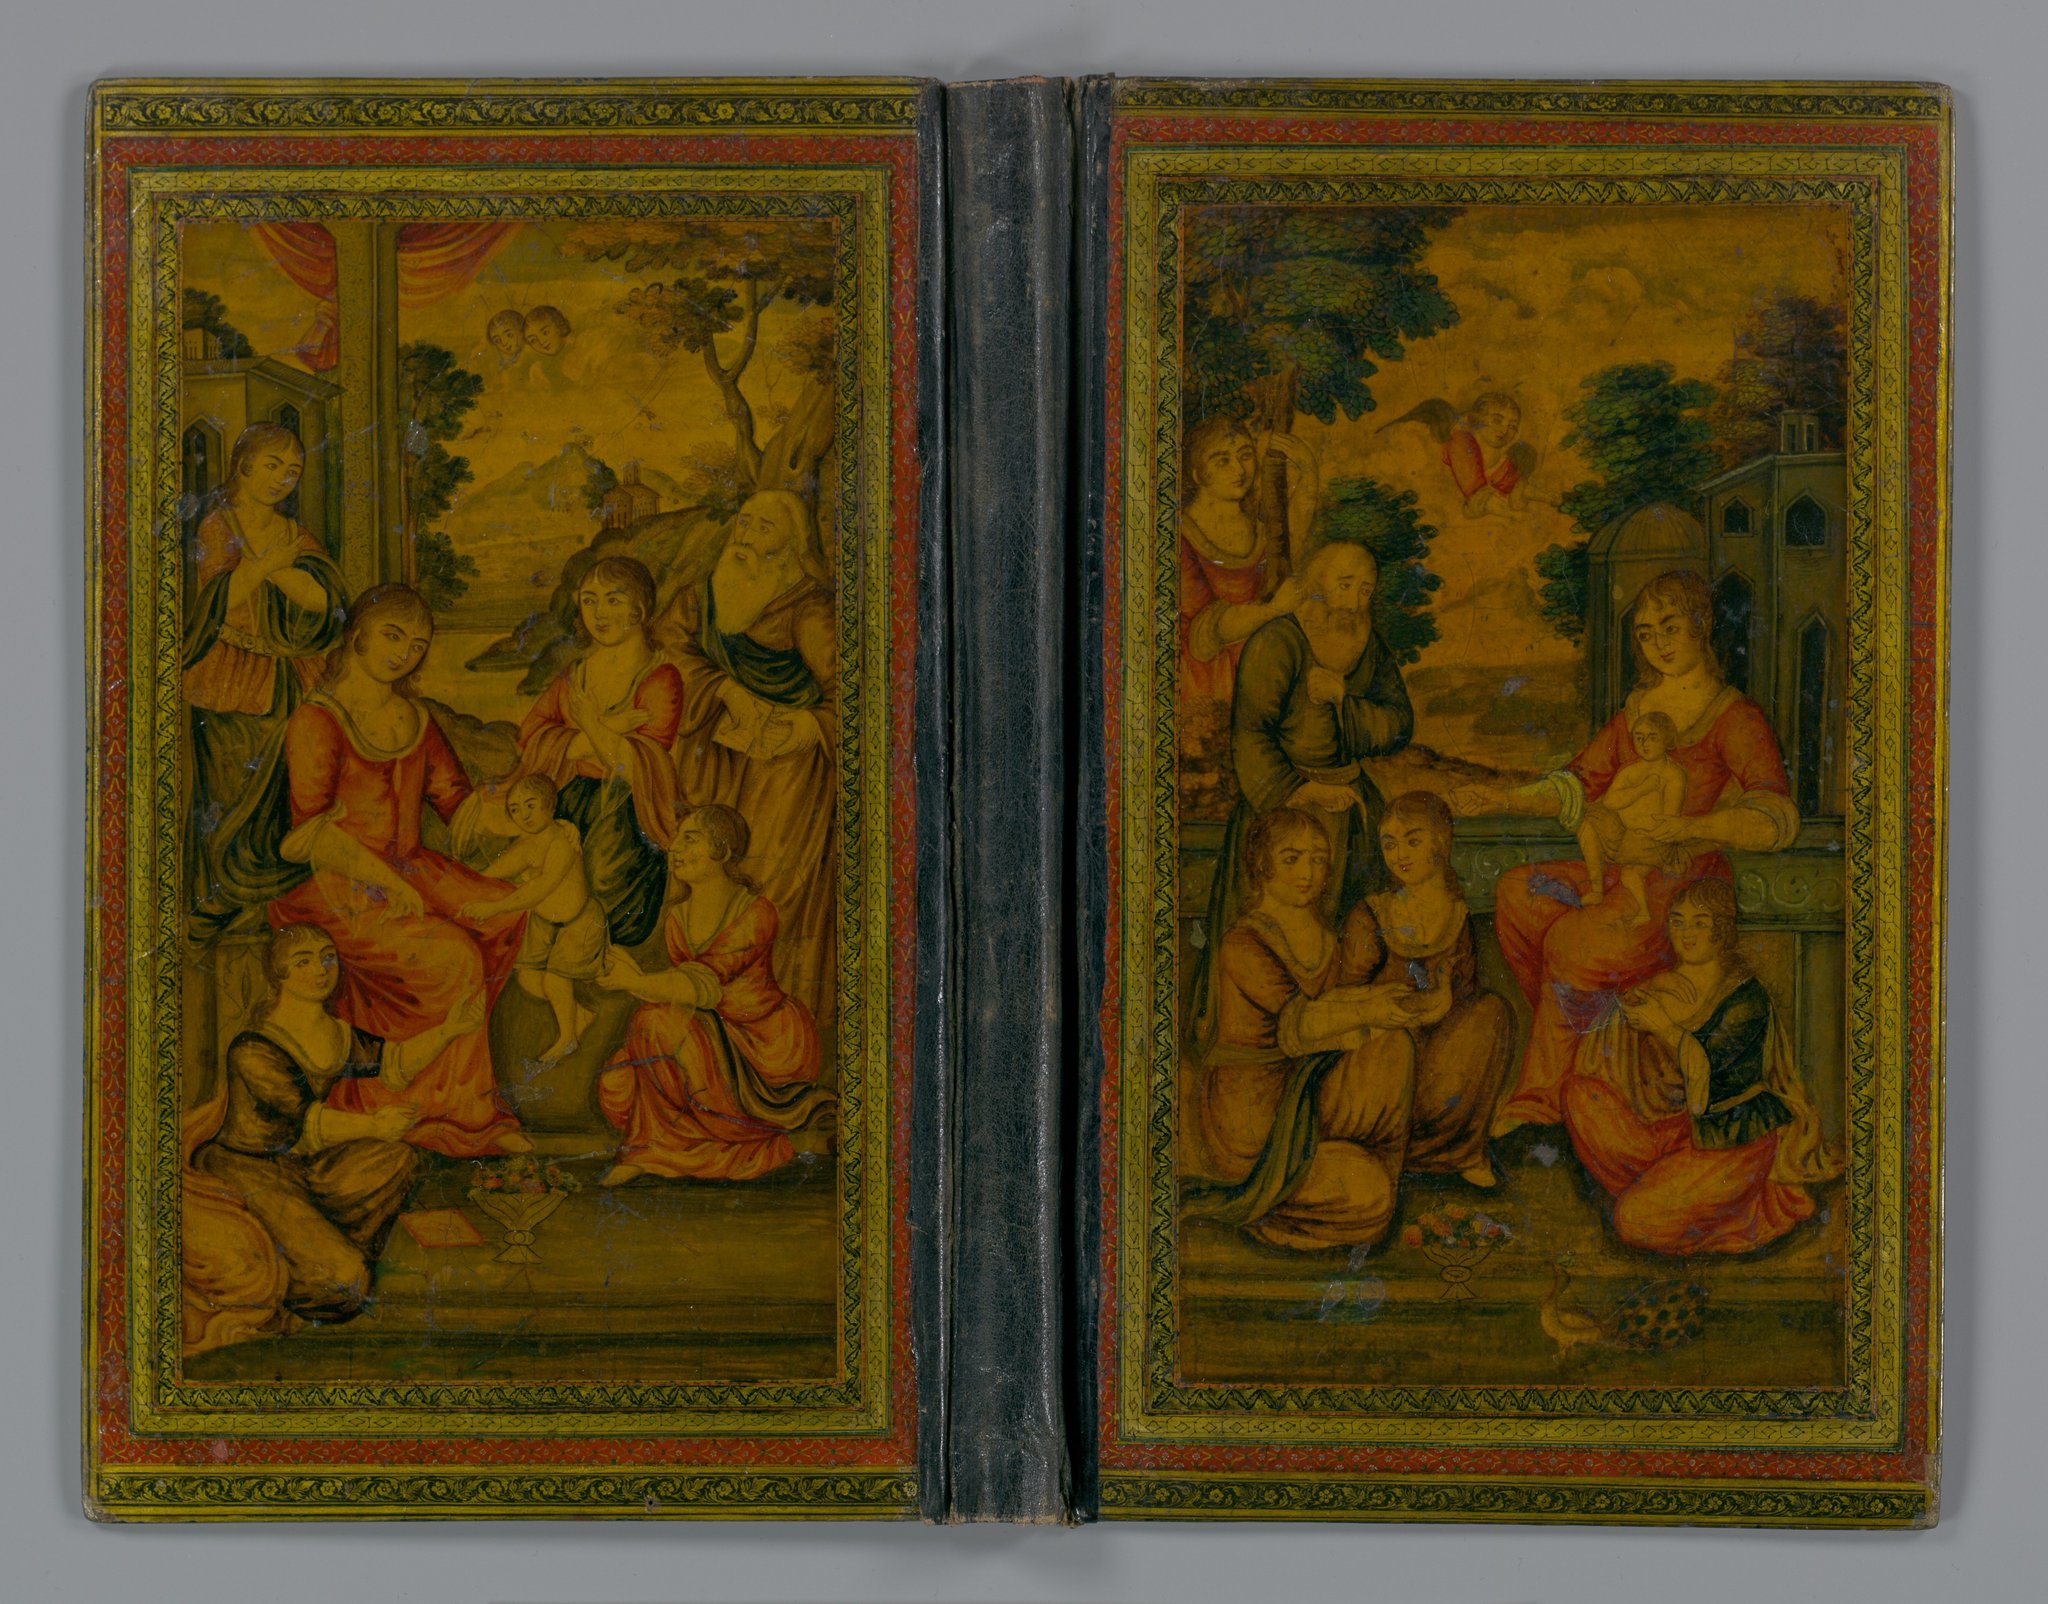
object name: bookbinding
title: Bookcover with Christian Themes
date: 1834-1866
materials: board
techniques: lacquer, painting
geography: iran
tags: children,men,women